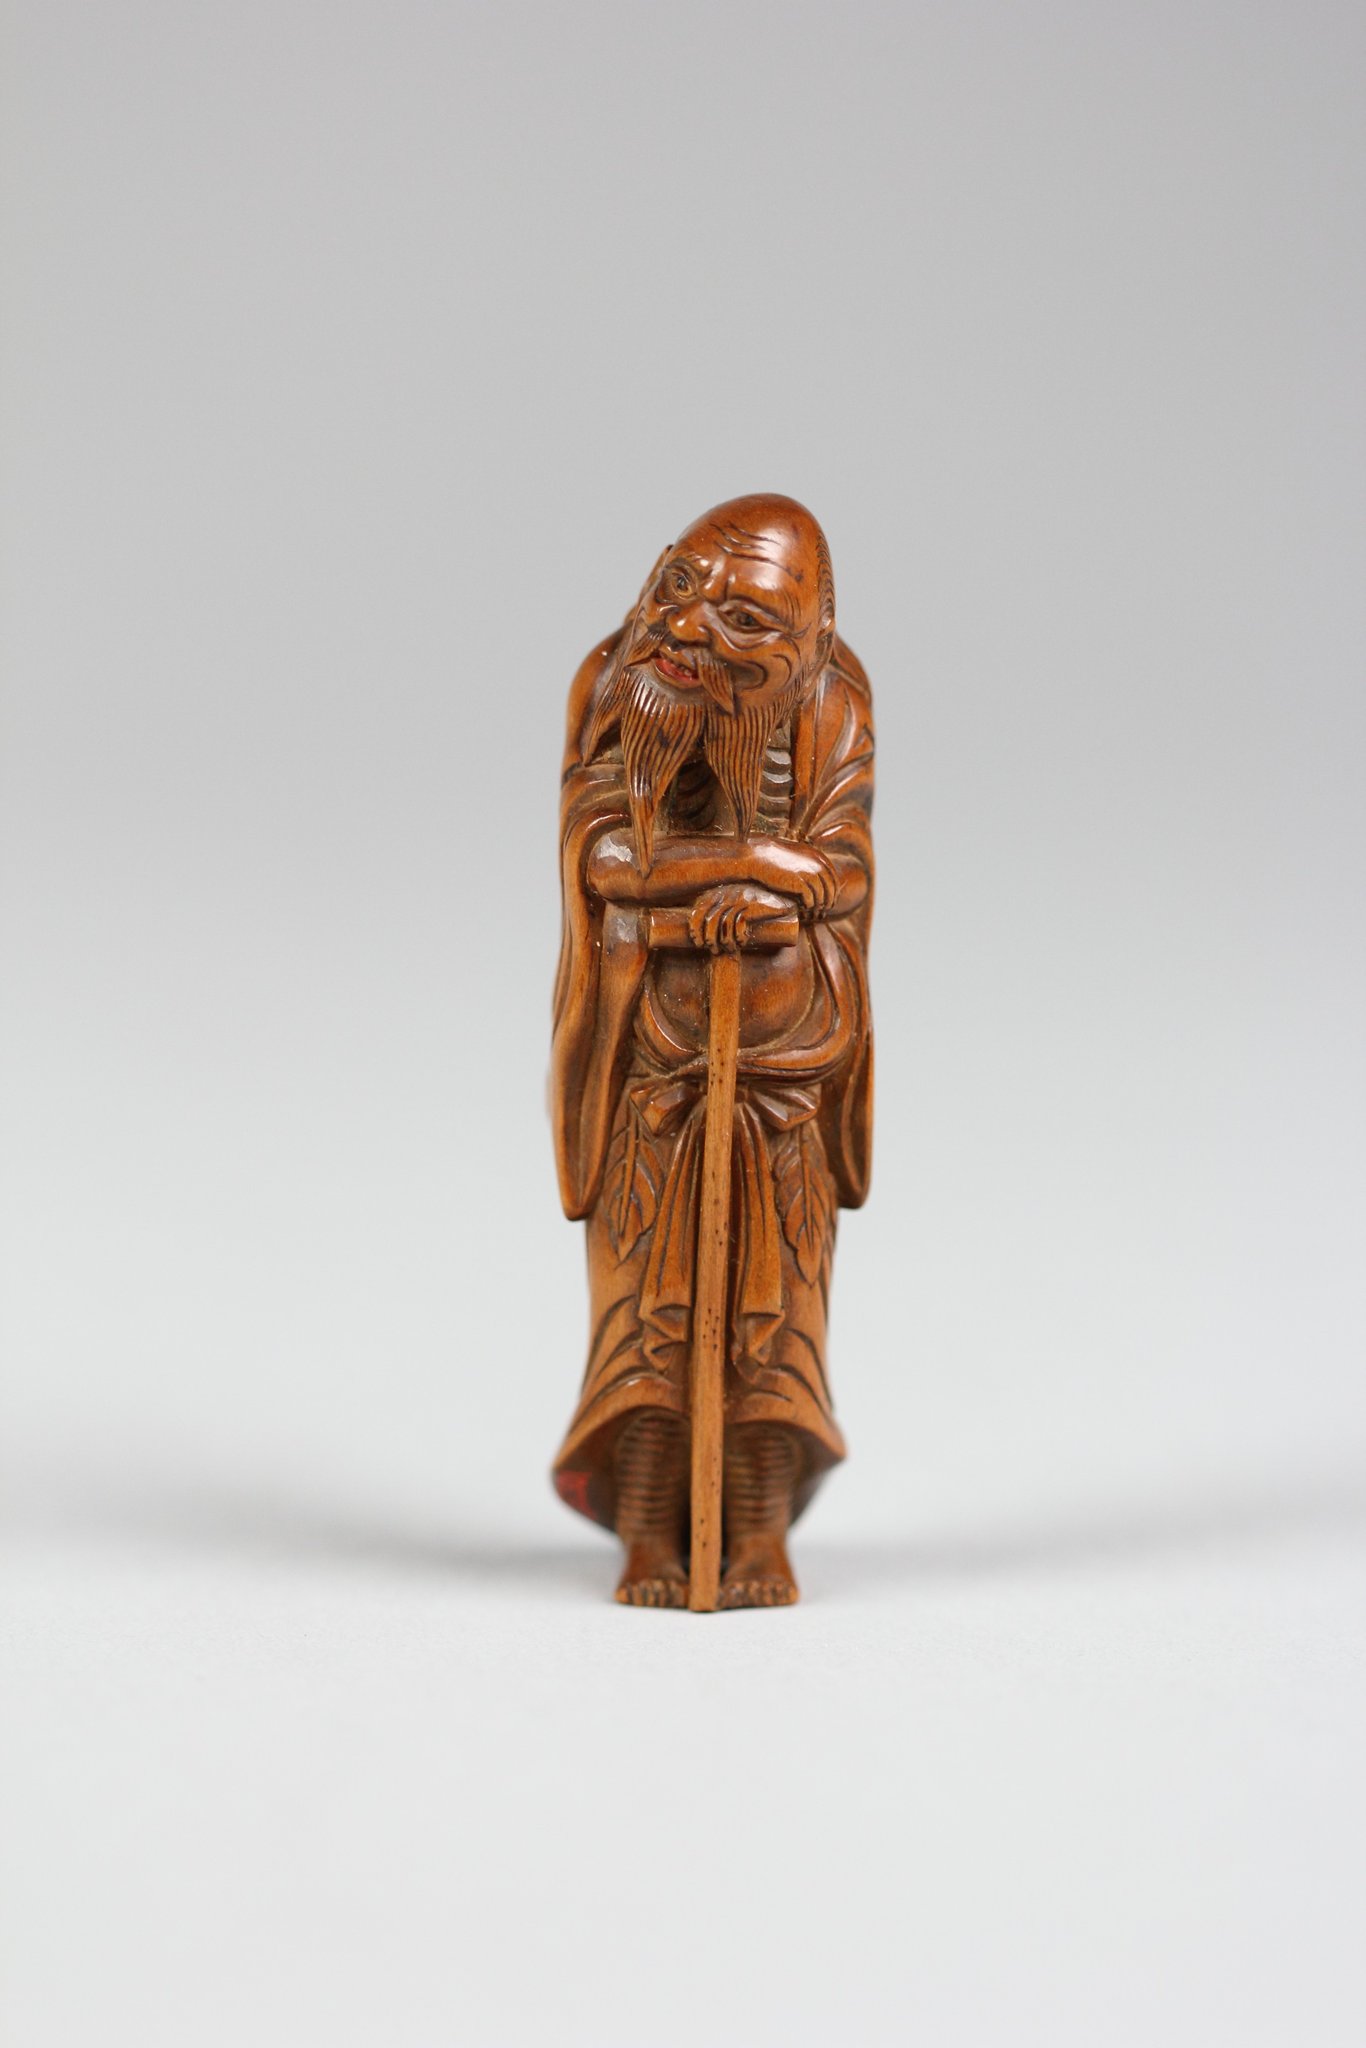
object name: netsuke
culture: japanese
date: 1801-1900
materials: wood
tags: men